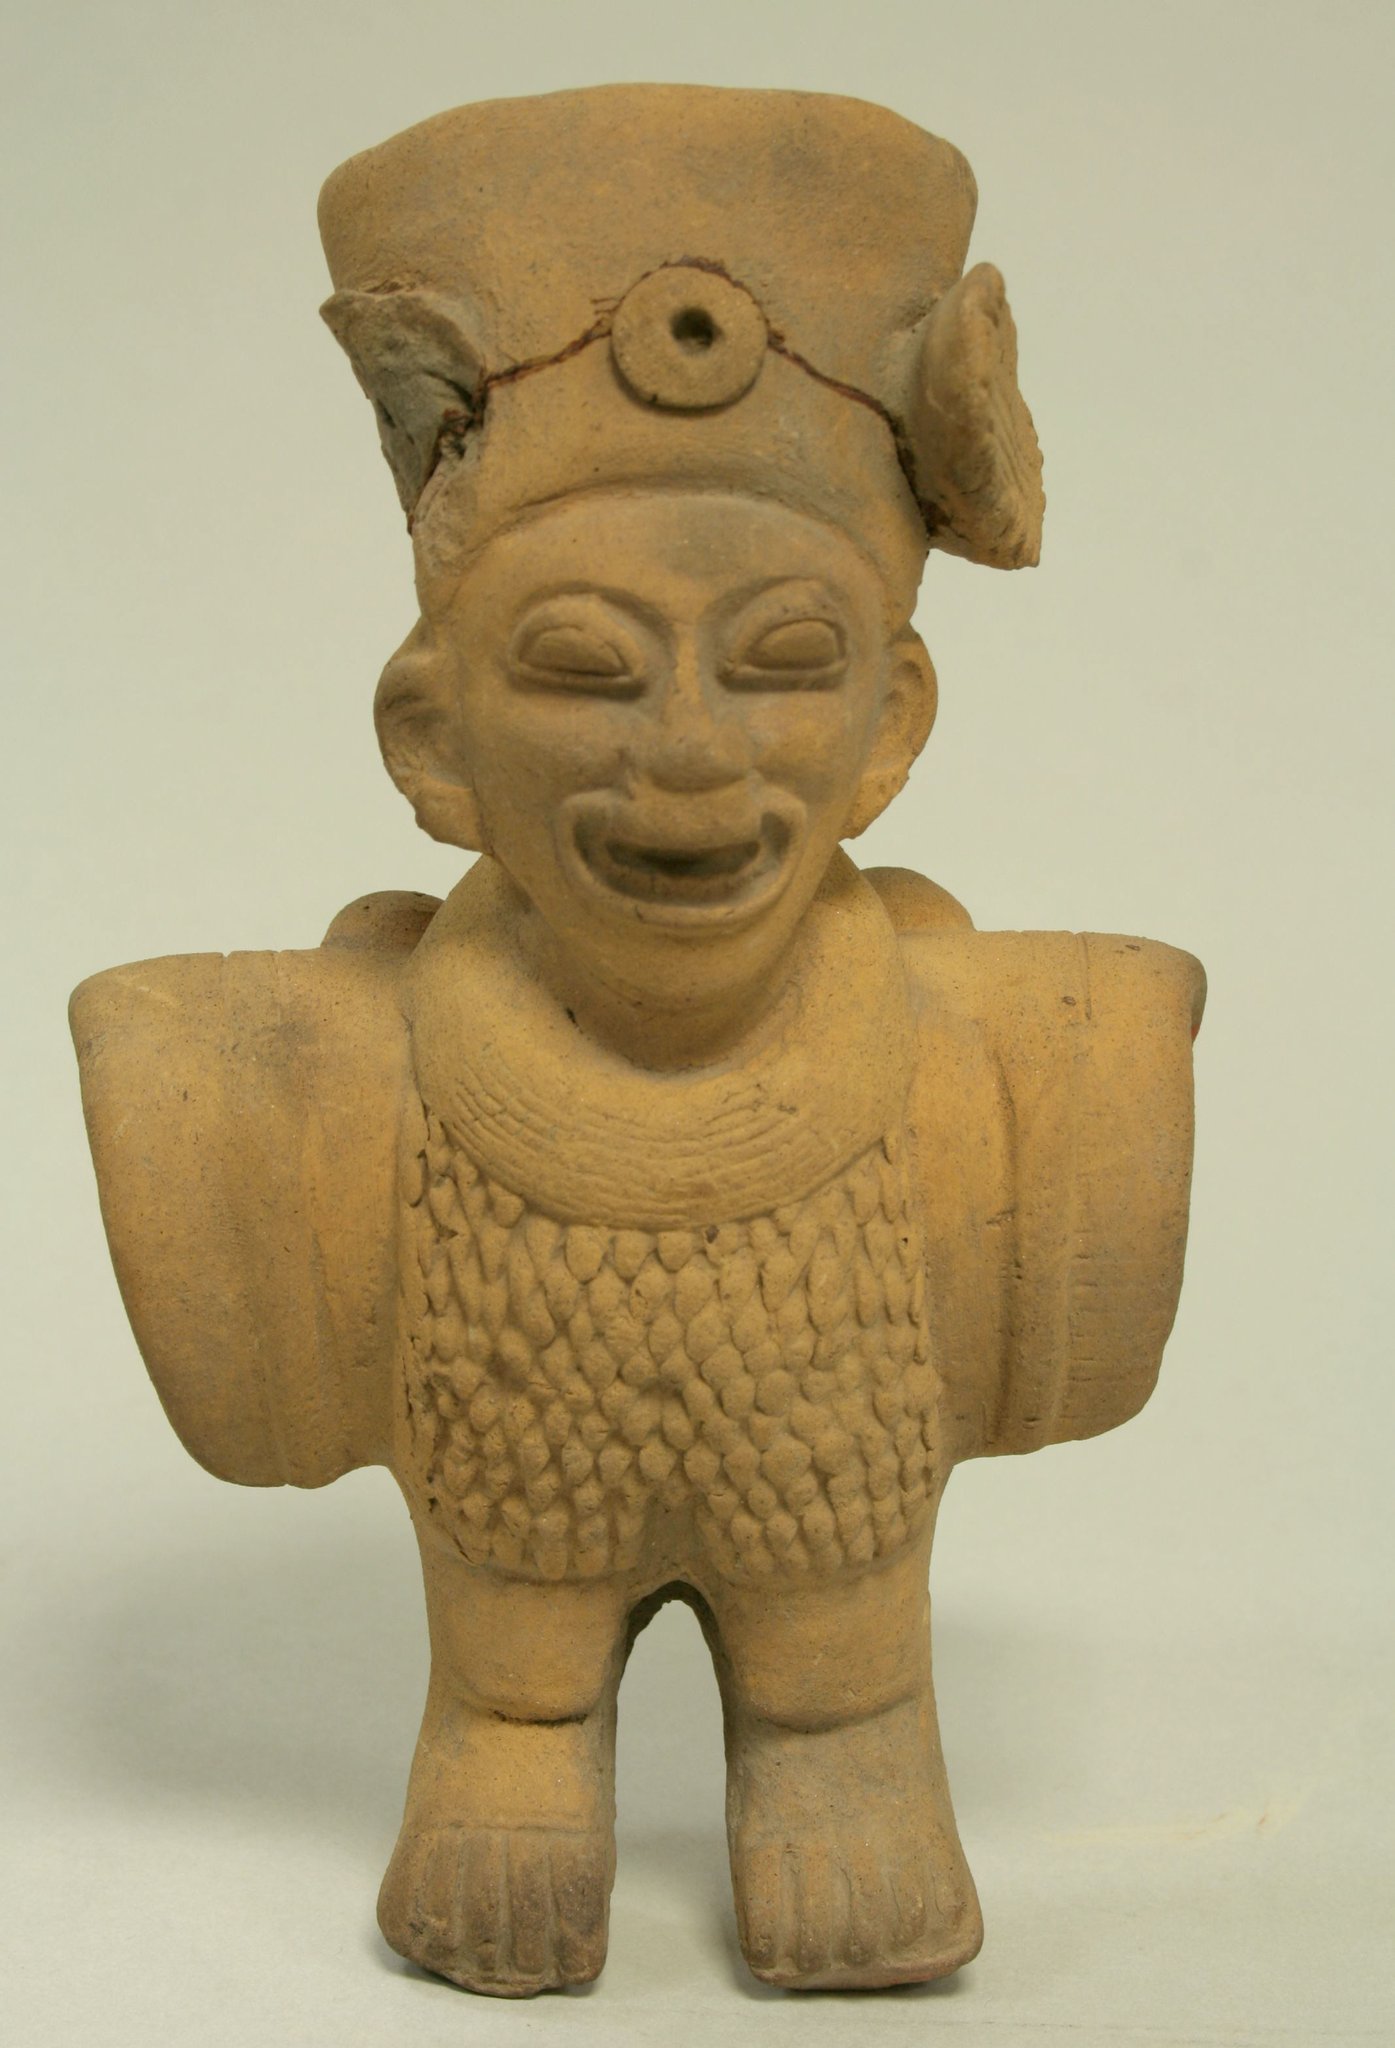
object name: figure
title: Anthropomorphic Bird Figure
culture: jama-coaque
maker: jama-coaque artist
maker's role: artist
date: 240 BCE-450 CE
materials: ceramic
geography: colombia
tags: mythical creatures